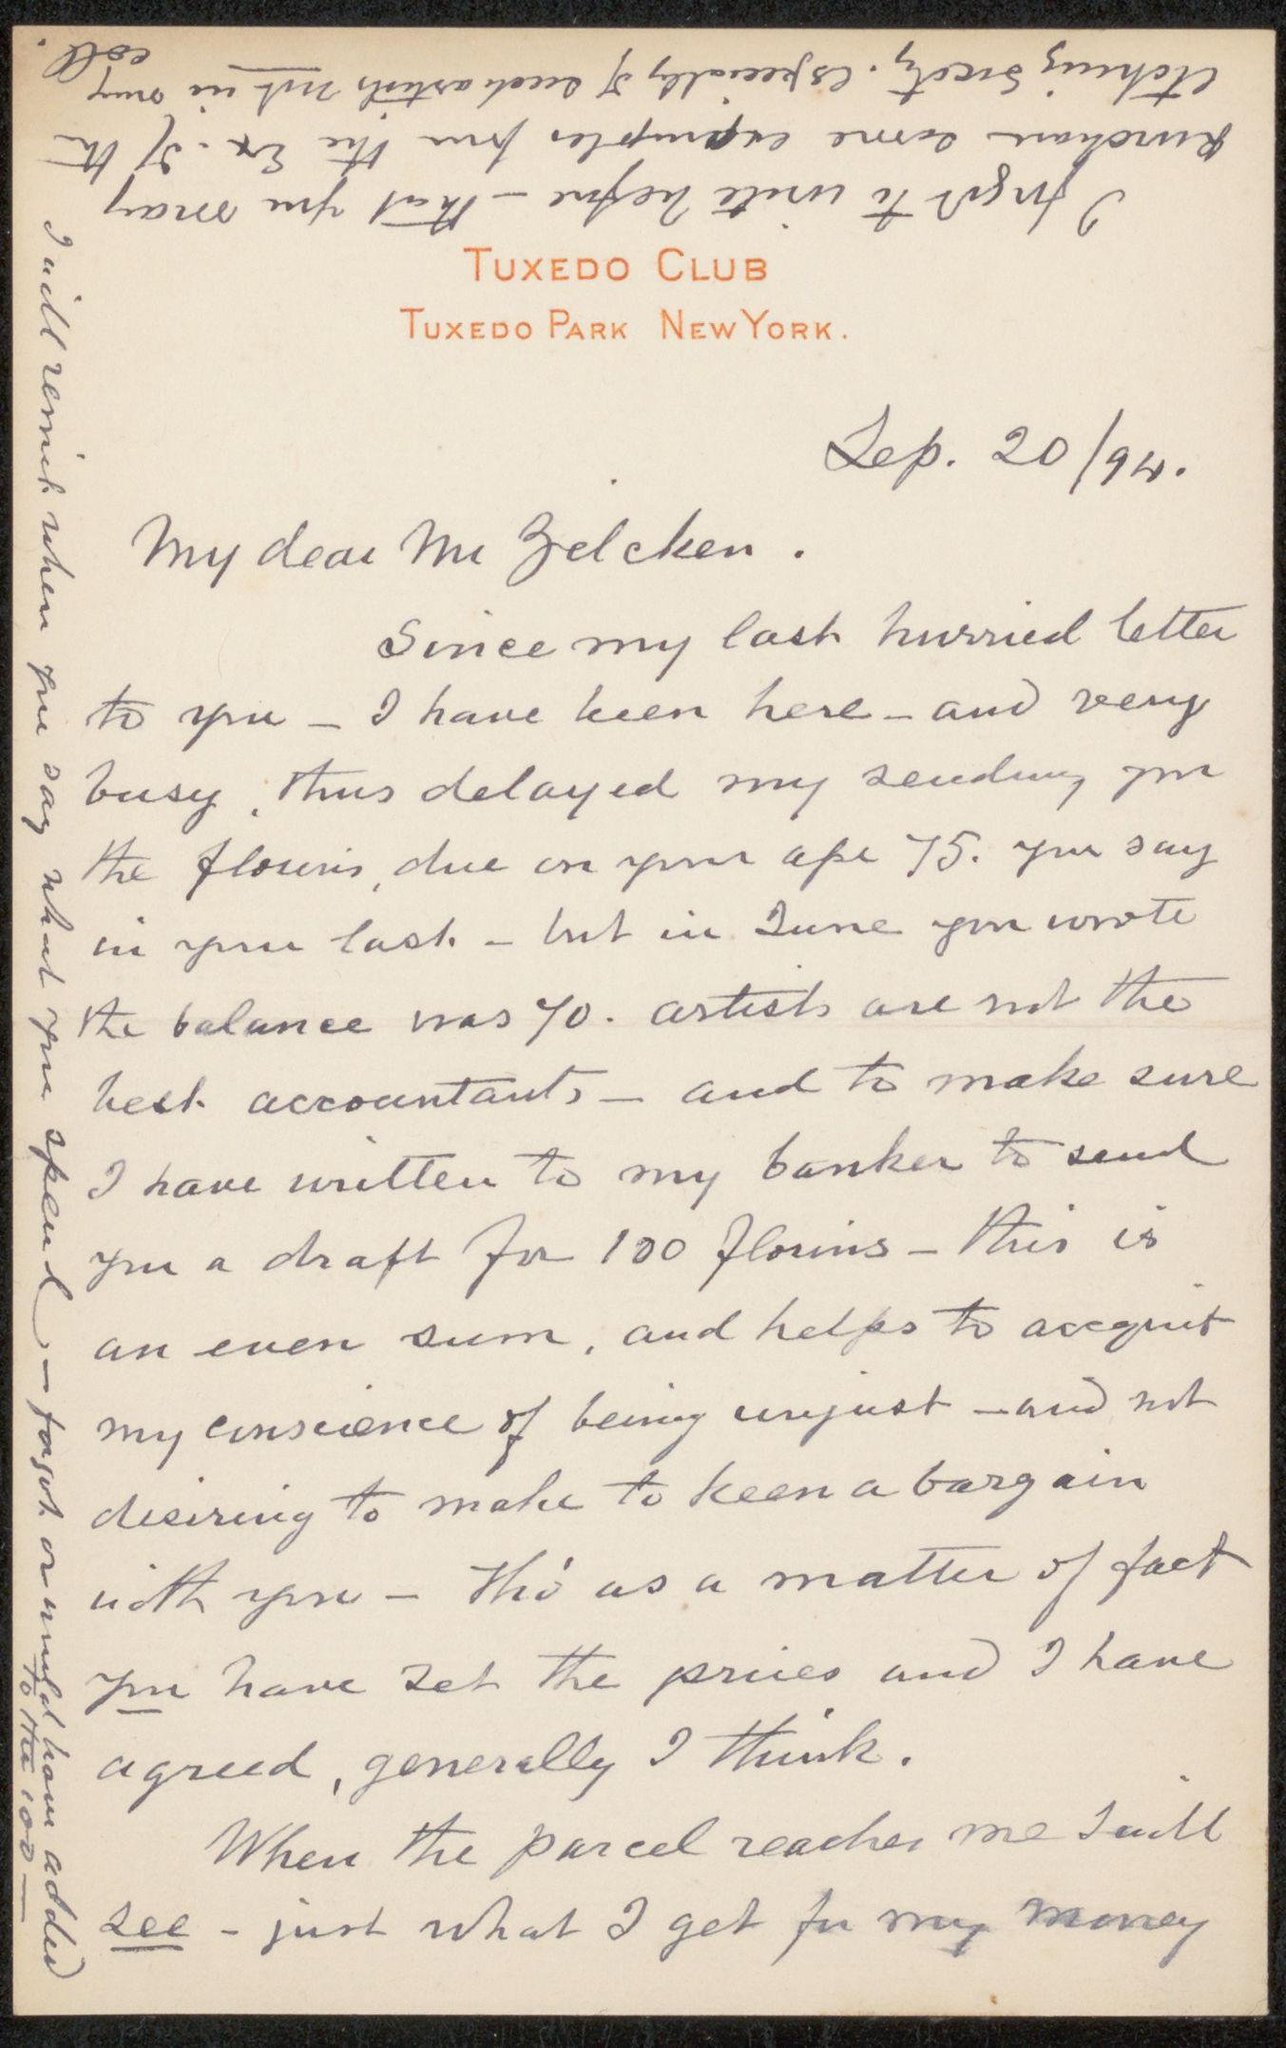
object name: letter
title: Brief aan Philip Zilcken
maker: samuel putnam avery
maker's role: verzamelaar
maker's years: 1822-1904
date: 1894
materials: ink, paper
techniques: pen, printing, writing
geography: new york city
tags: the hague, draughtsman, philip zilcken, art trade, art shop, the graphic arts, art collecting, money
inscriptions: watermark, collector's mark: ‘RPK’